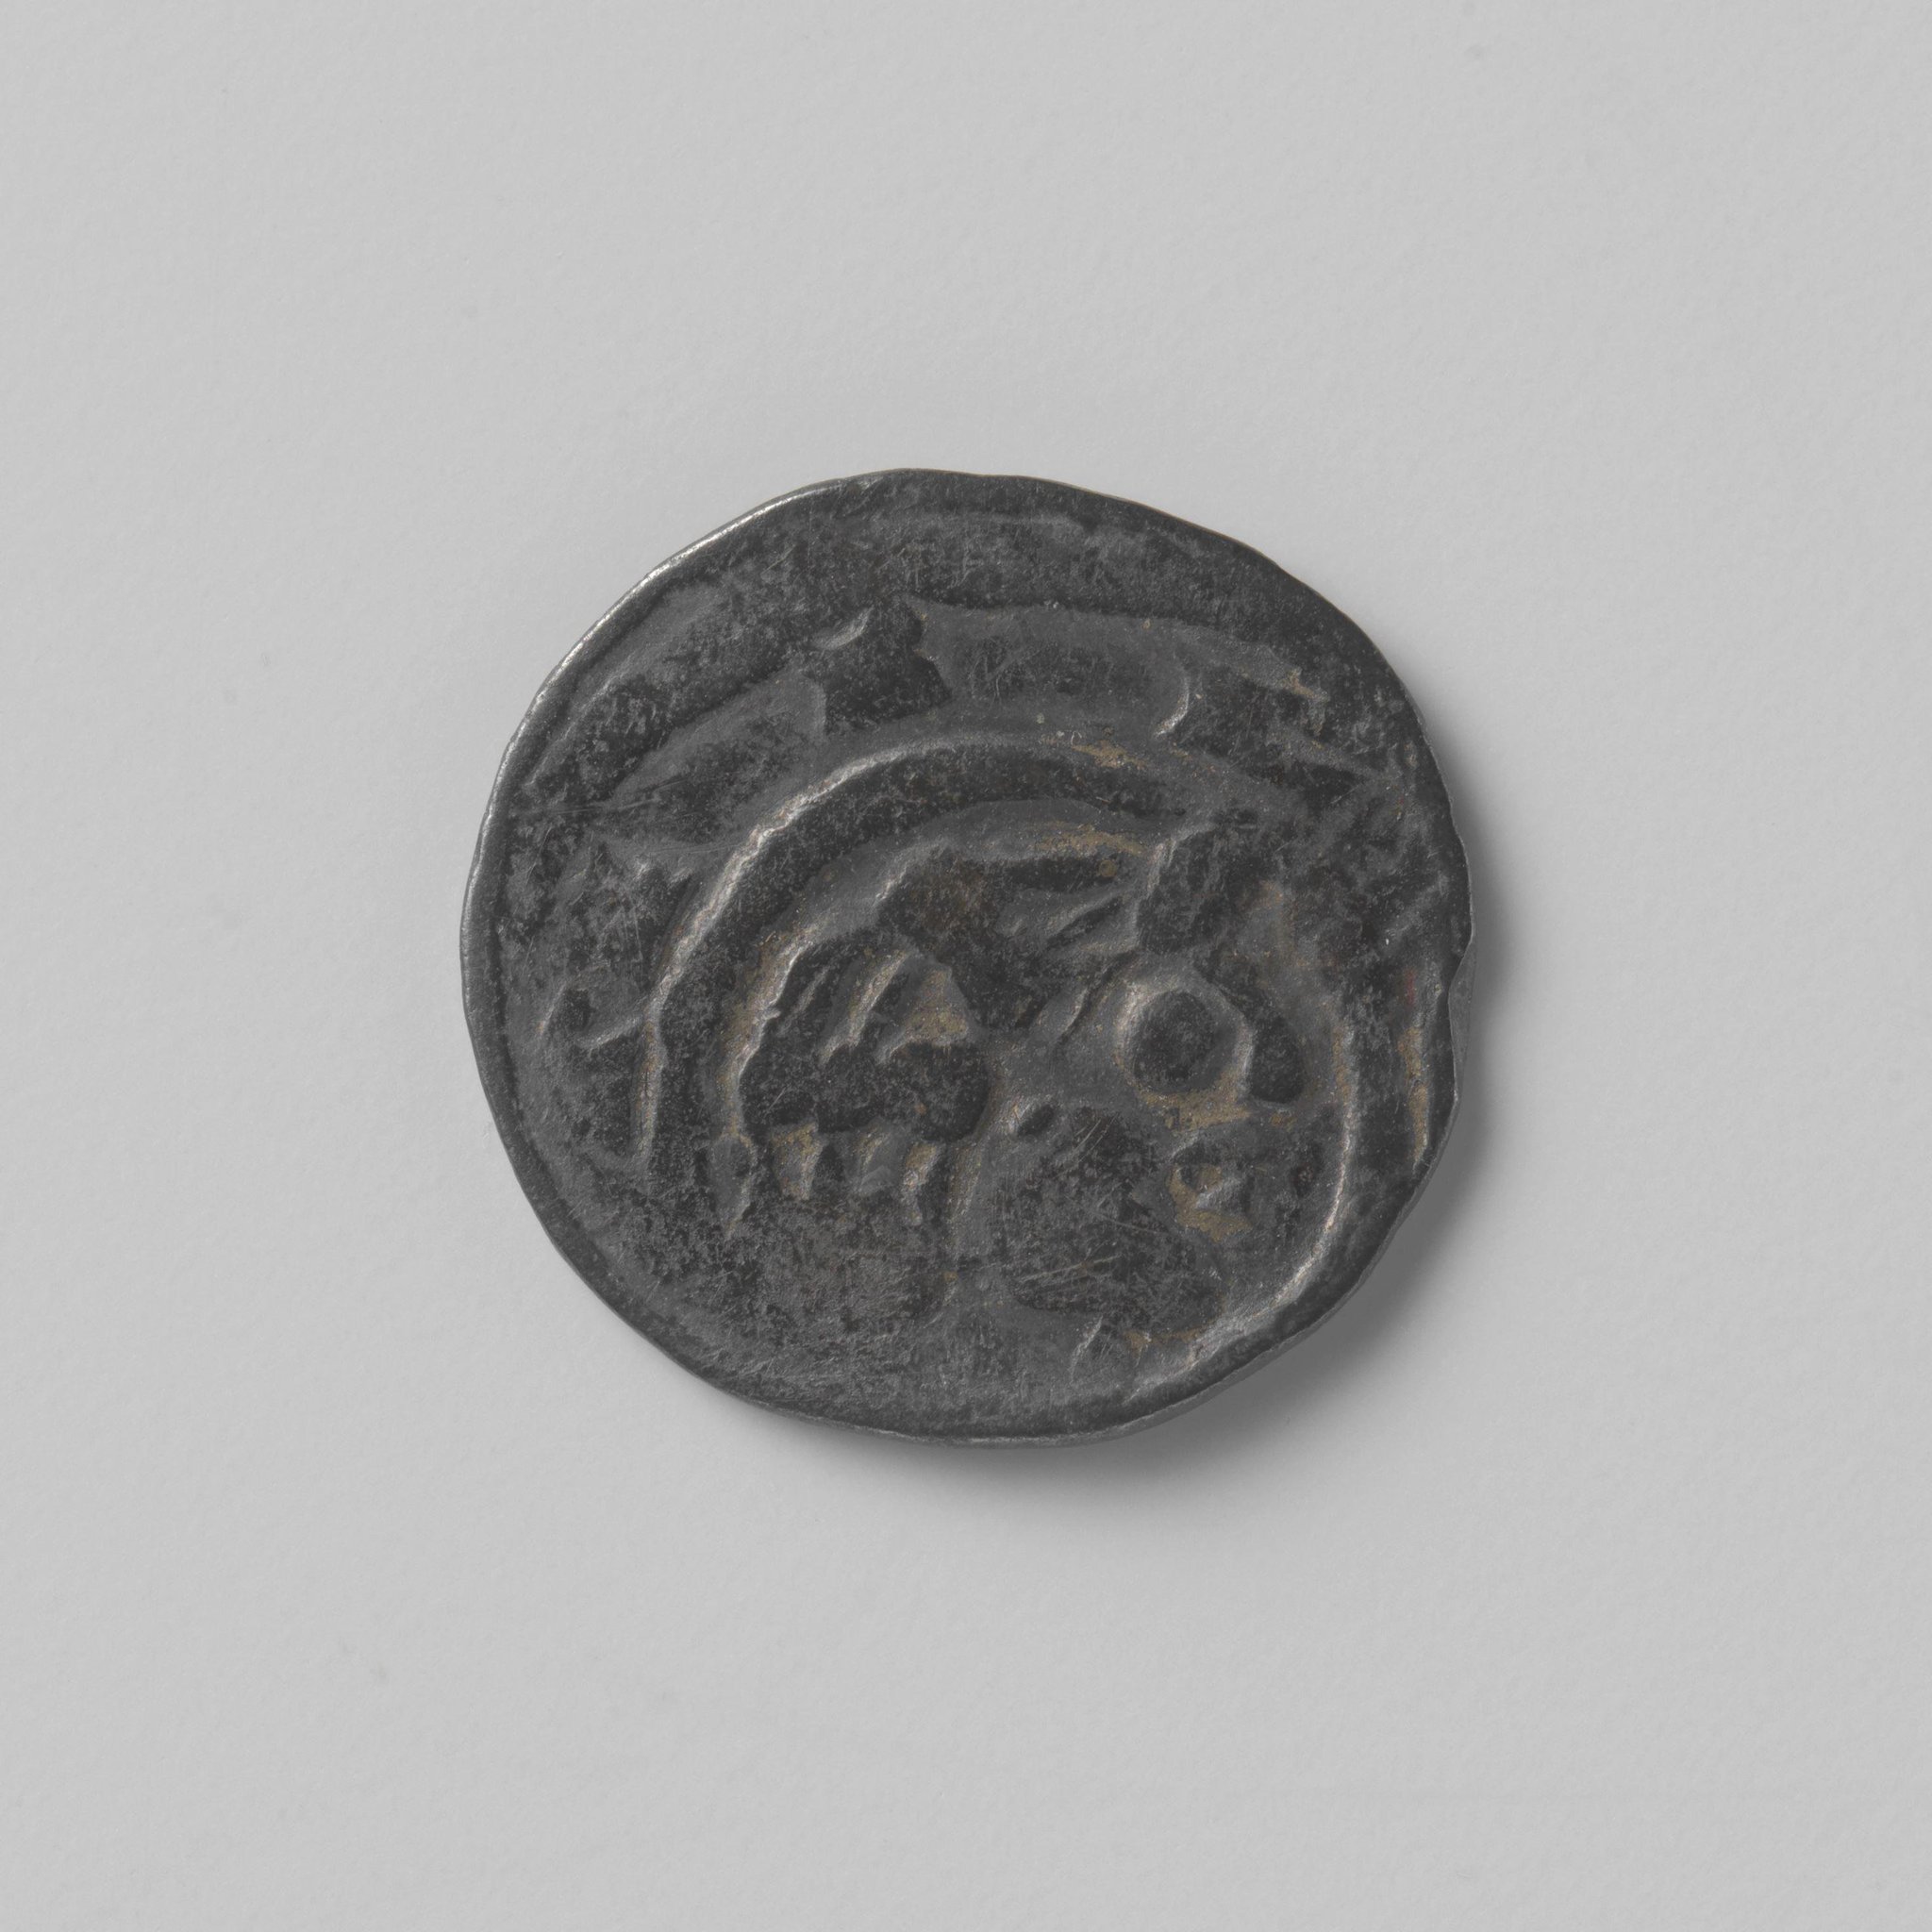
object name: penny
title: Hollandse penning van Floris IV, 1222-1234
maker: floris iv (graaf van holland)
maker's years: 1210-1234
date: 1222-1234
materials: silver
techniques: striking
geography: dordrecht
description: Zilveren munt. Voorzijde: hoofd met gravenmuts naar rechts. Keerzijde: kort dubbellijnig kruis.